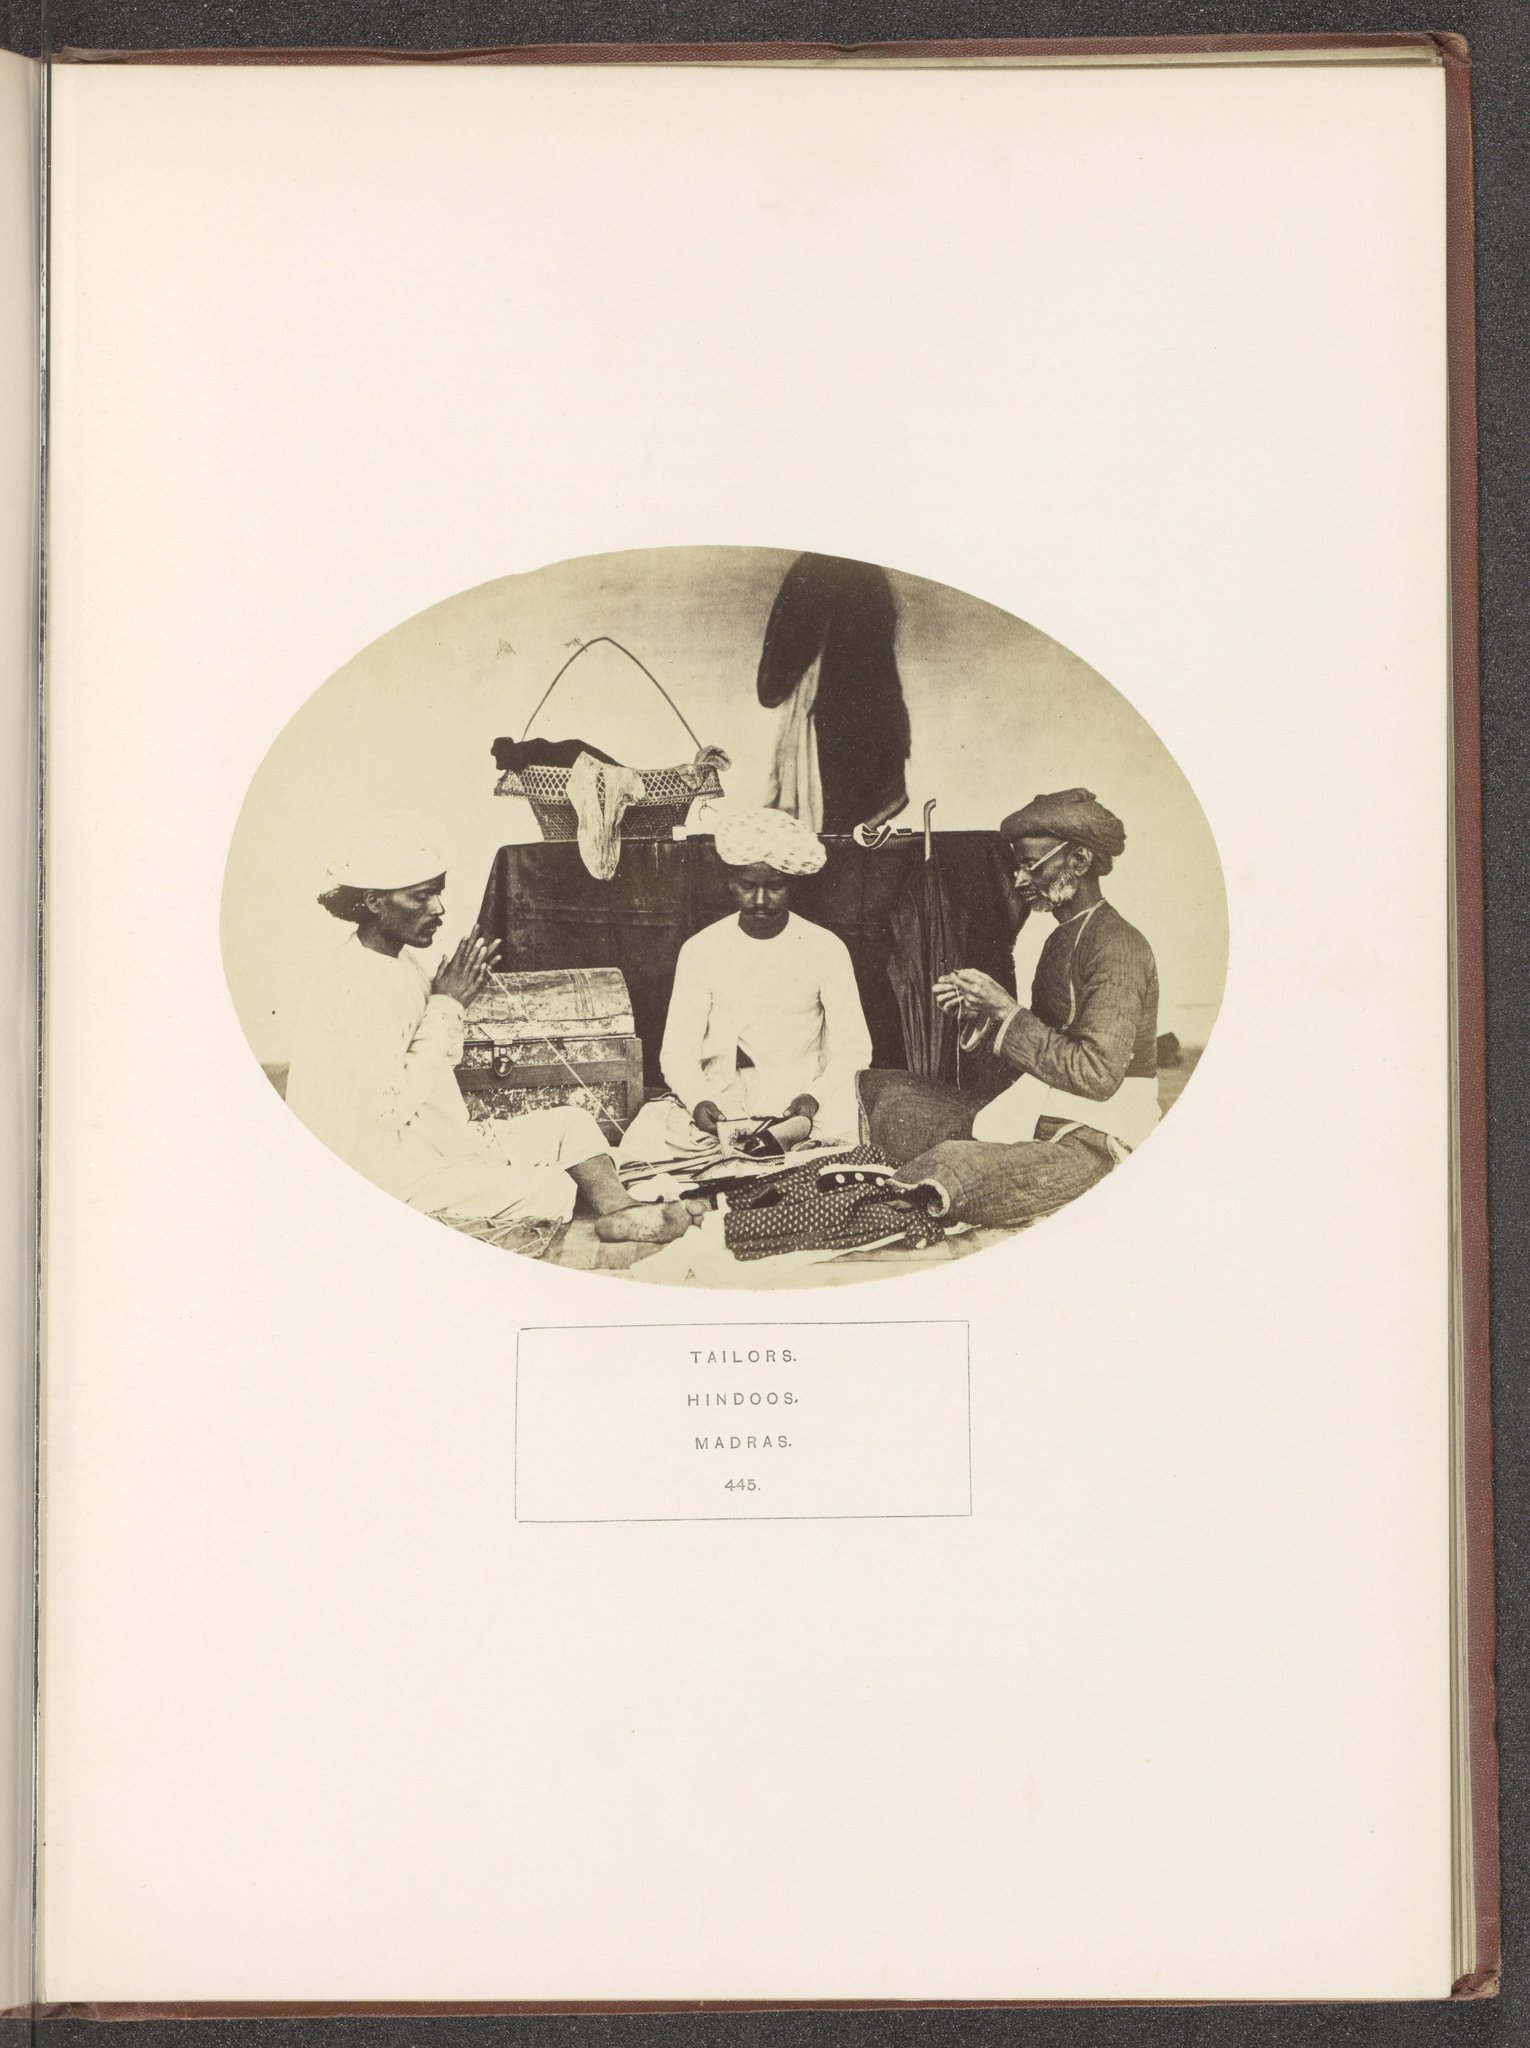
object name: page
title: Portrait of three unknown tailors at work in Chennai, Tamil Nadu, India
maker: Anonymous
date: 1865-1875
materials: photographic support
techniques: albumen print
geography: chennai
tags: human races; peoples; nationalities, tailor, dressmaker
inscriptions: inscription: ‘TAILORS./ HINDOOS./ MADRAS.’, number: ‘445.’